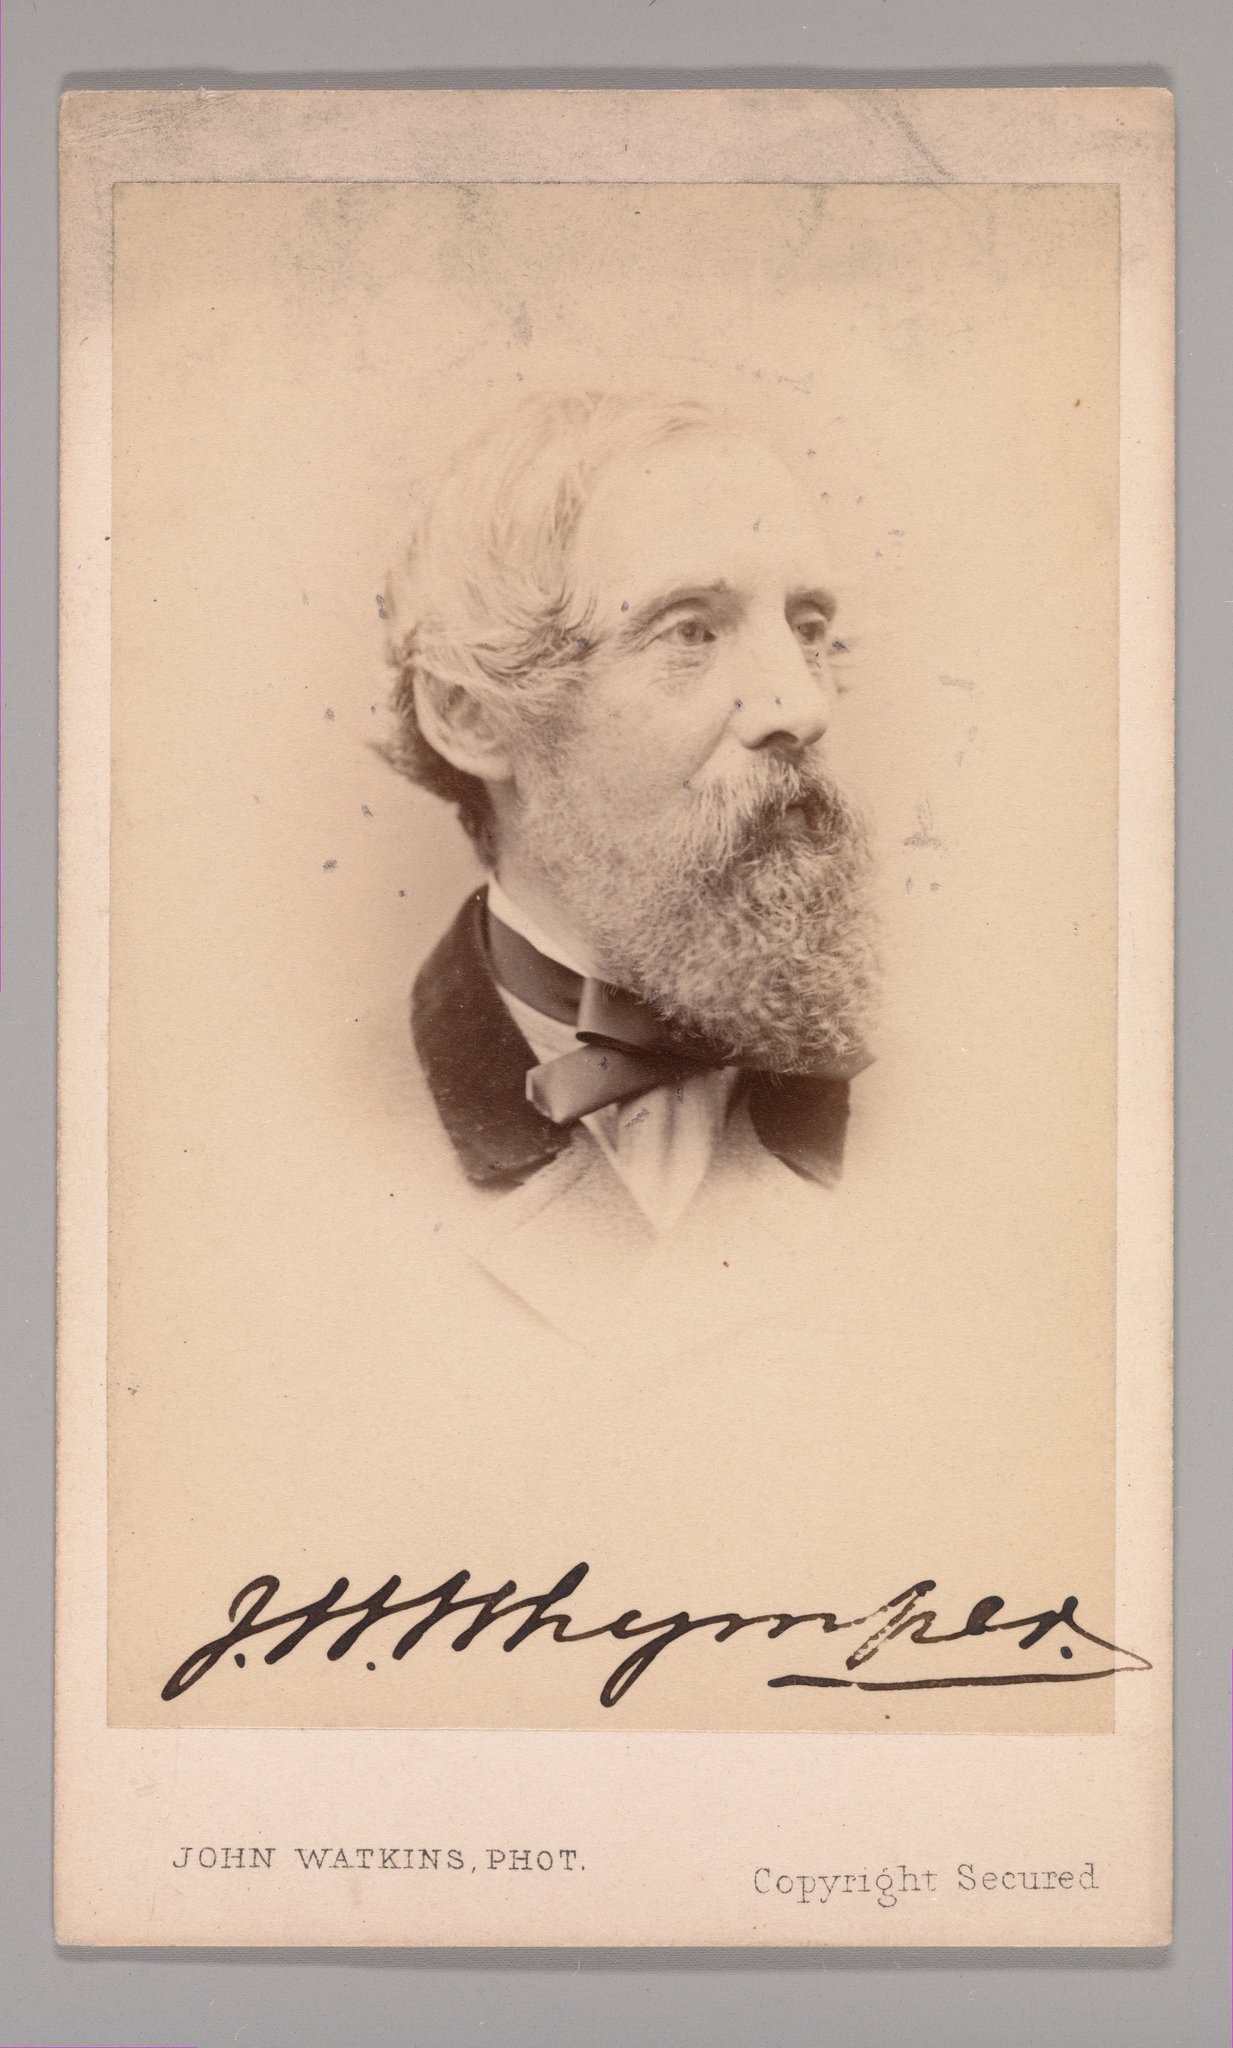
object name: carte de visite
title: [Josiah Wood Whymper]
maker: john and charles watkins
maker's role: photography studio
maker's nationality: british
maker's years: 1840-1875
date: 1860-1869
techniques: albumen silver print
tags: men,portraits